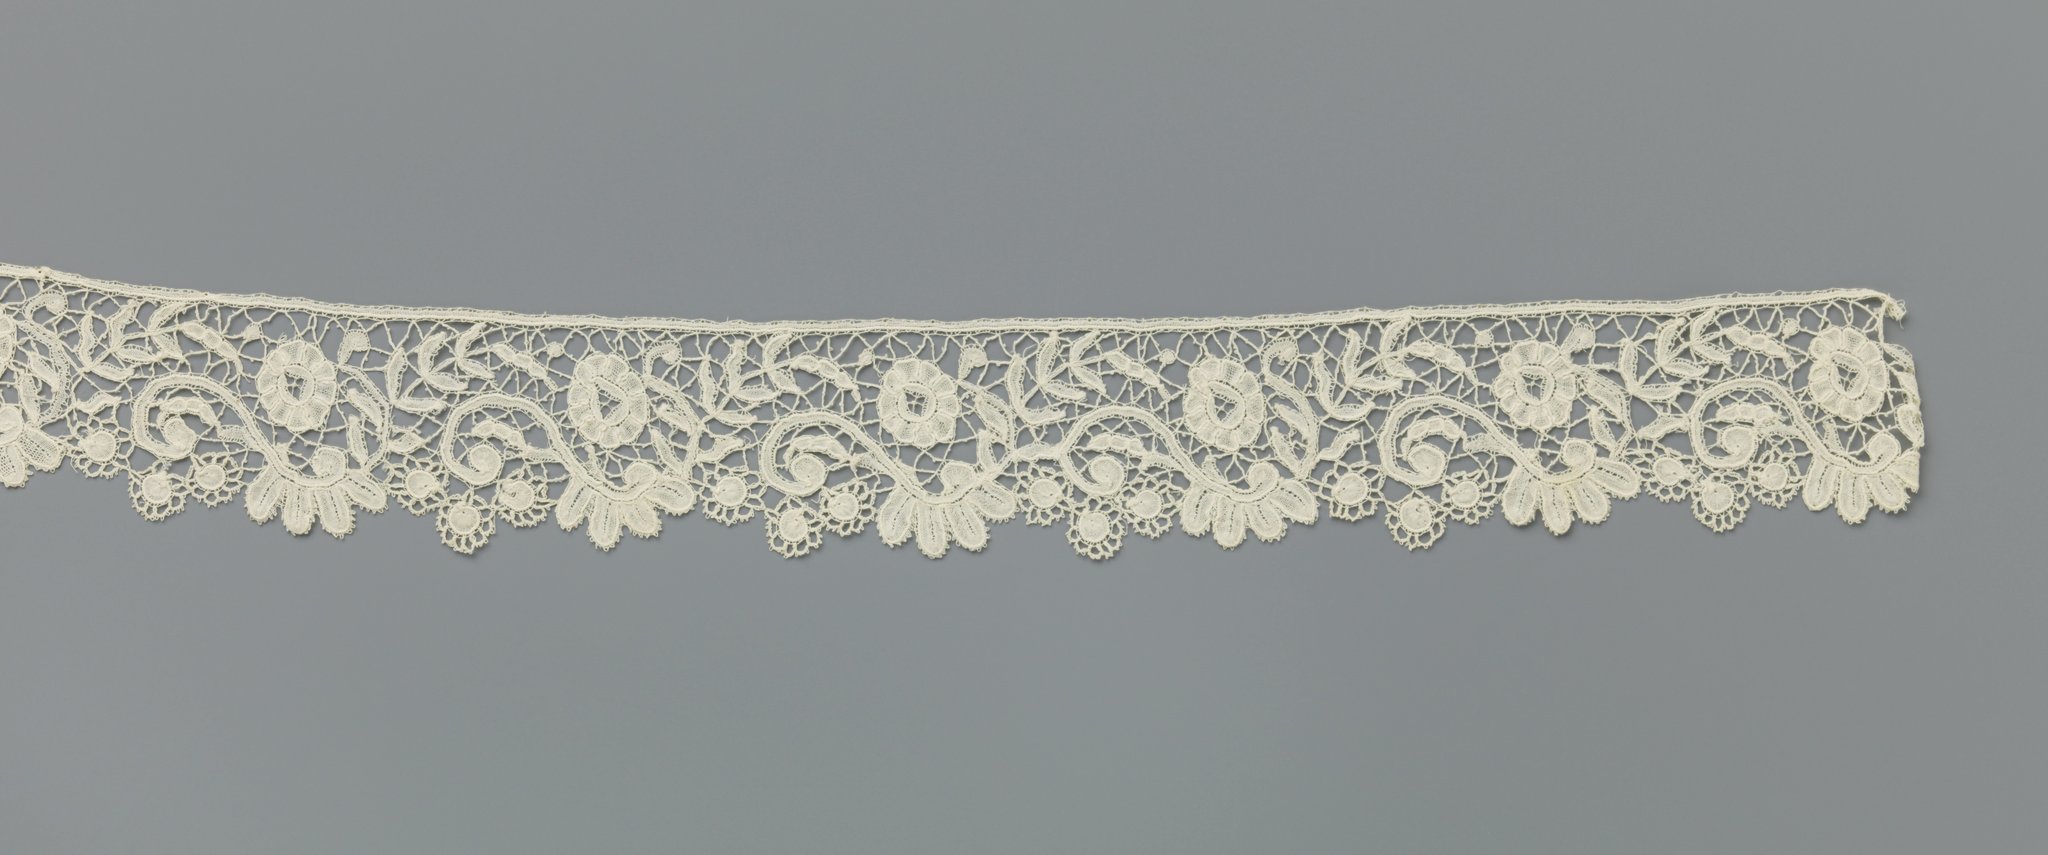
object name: strip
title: Strook kloskant met s-ranken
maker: Anonymous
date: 1875-1899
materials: linen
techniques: lace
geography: belgium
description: Strook naturelkleurige kloskant: duchesse-kant. Op een vlechtengrond staat een lopend patroon. S-ranken met een drietal madeliefjes en een randje van campanes vormen de schulpen en eindigen in een voluut met enkelvoudig roosje.